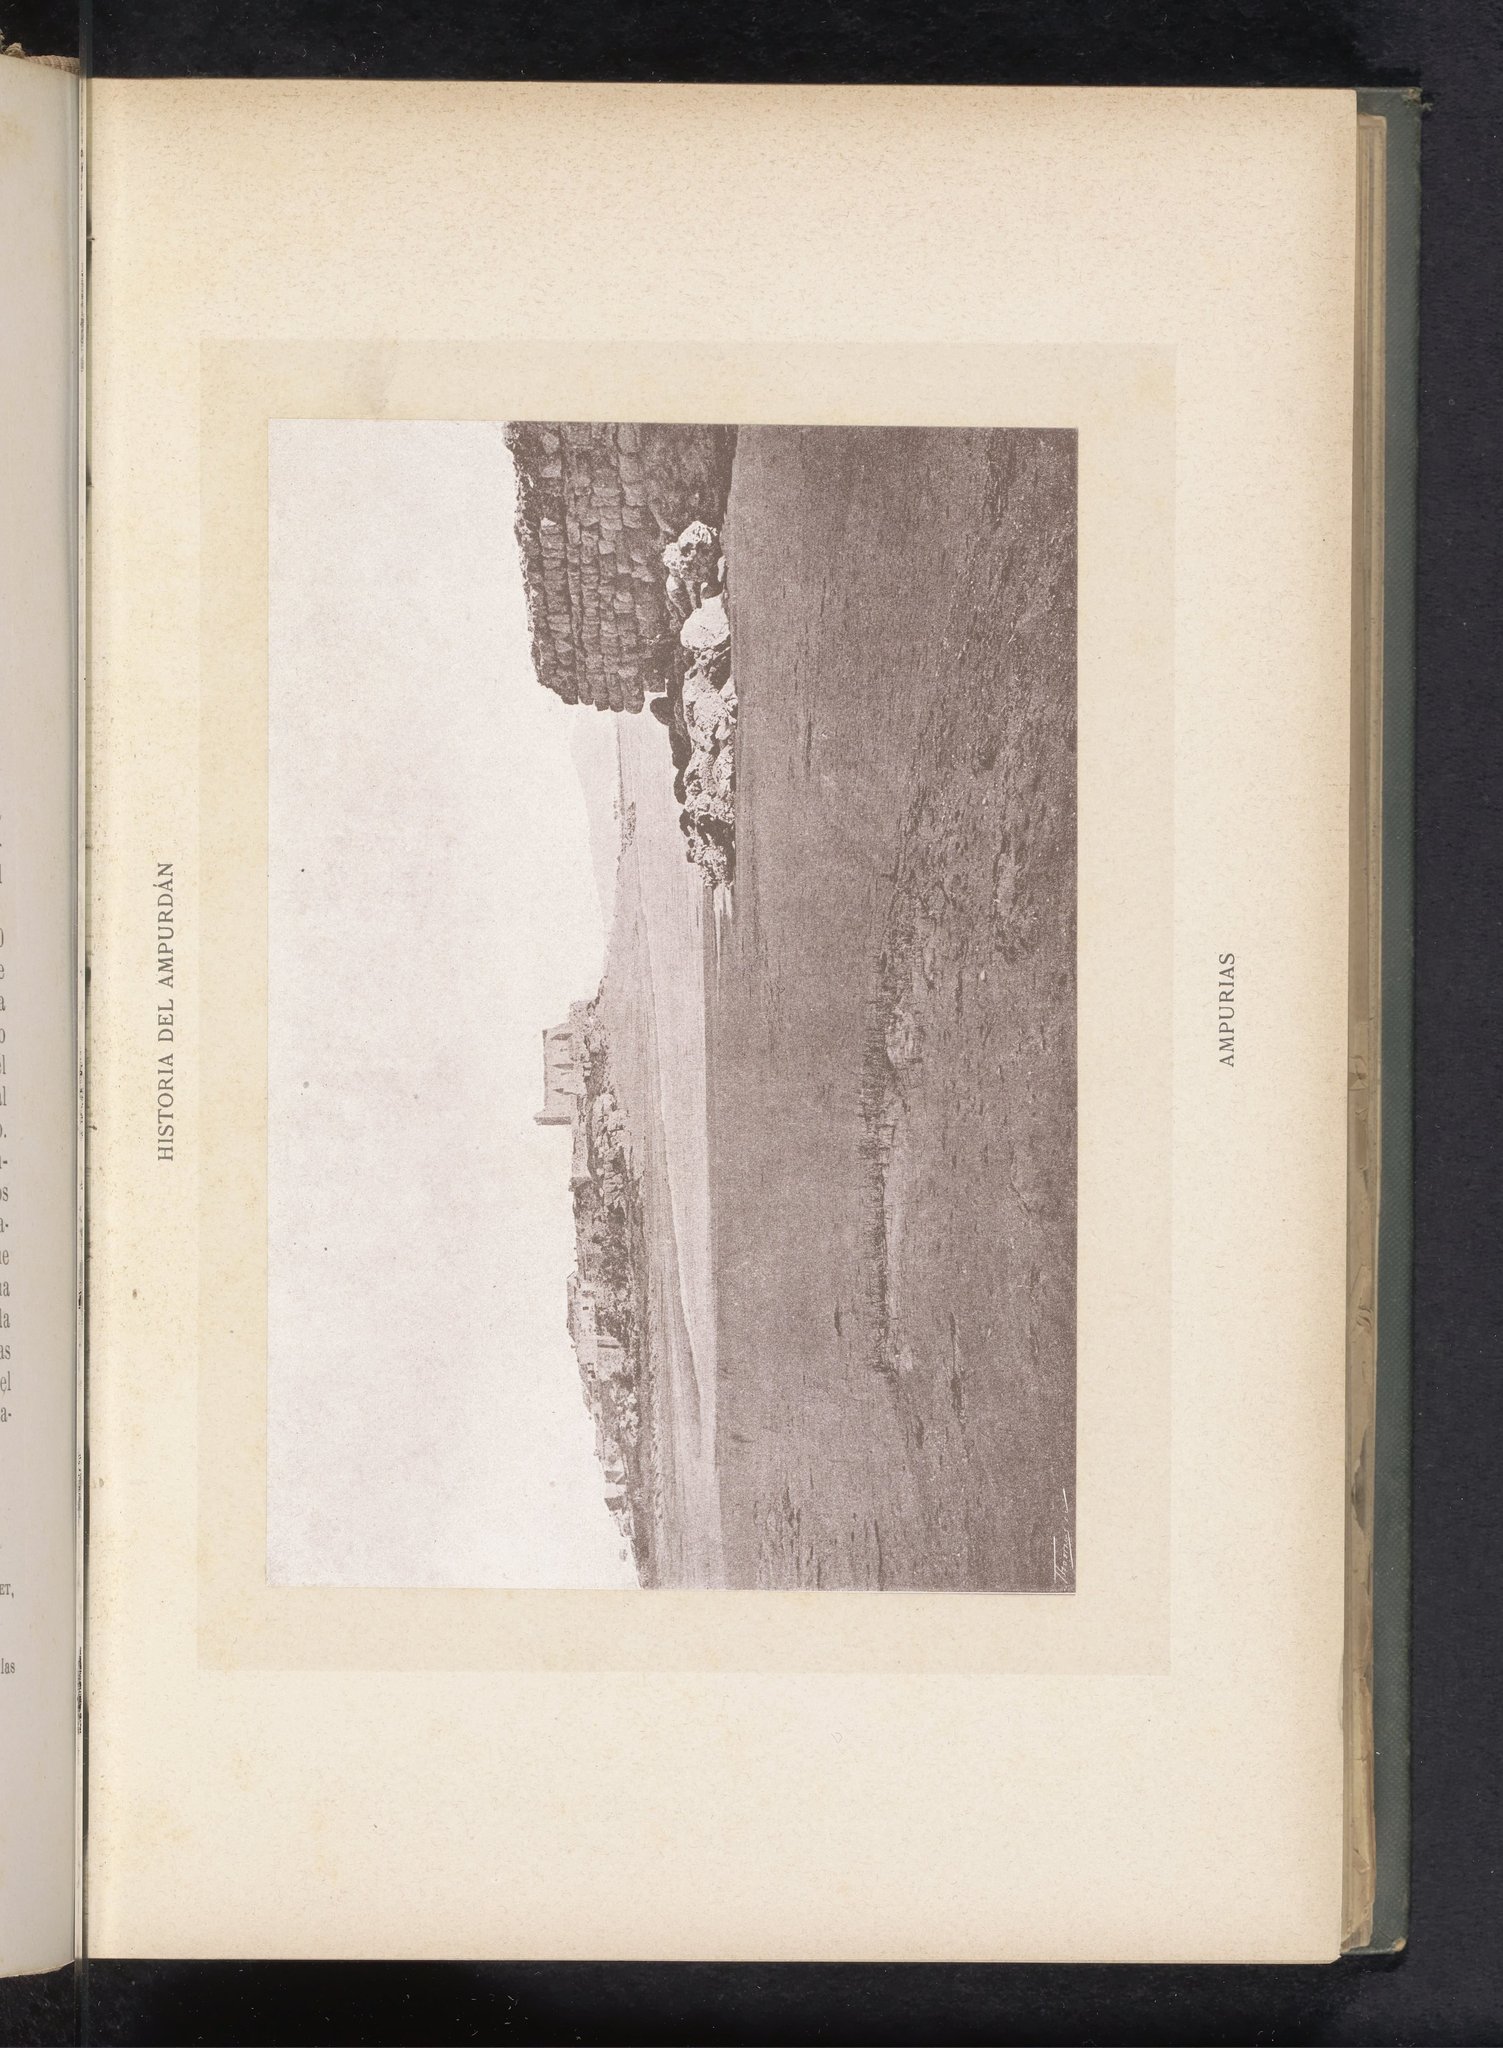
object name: page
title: Ampurias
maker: Anonymous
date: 1873-1883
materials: paper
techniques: photograph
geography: catalonia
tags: city-view in general; 'veduta'